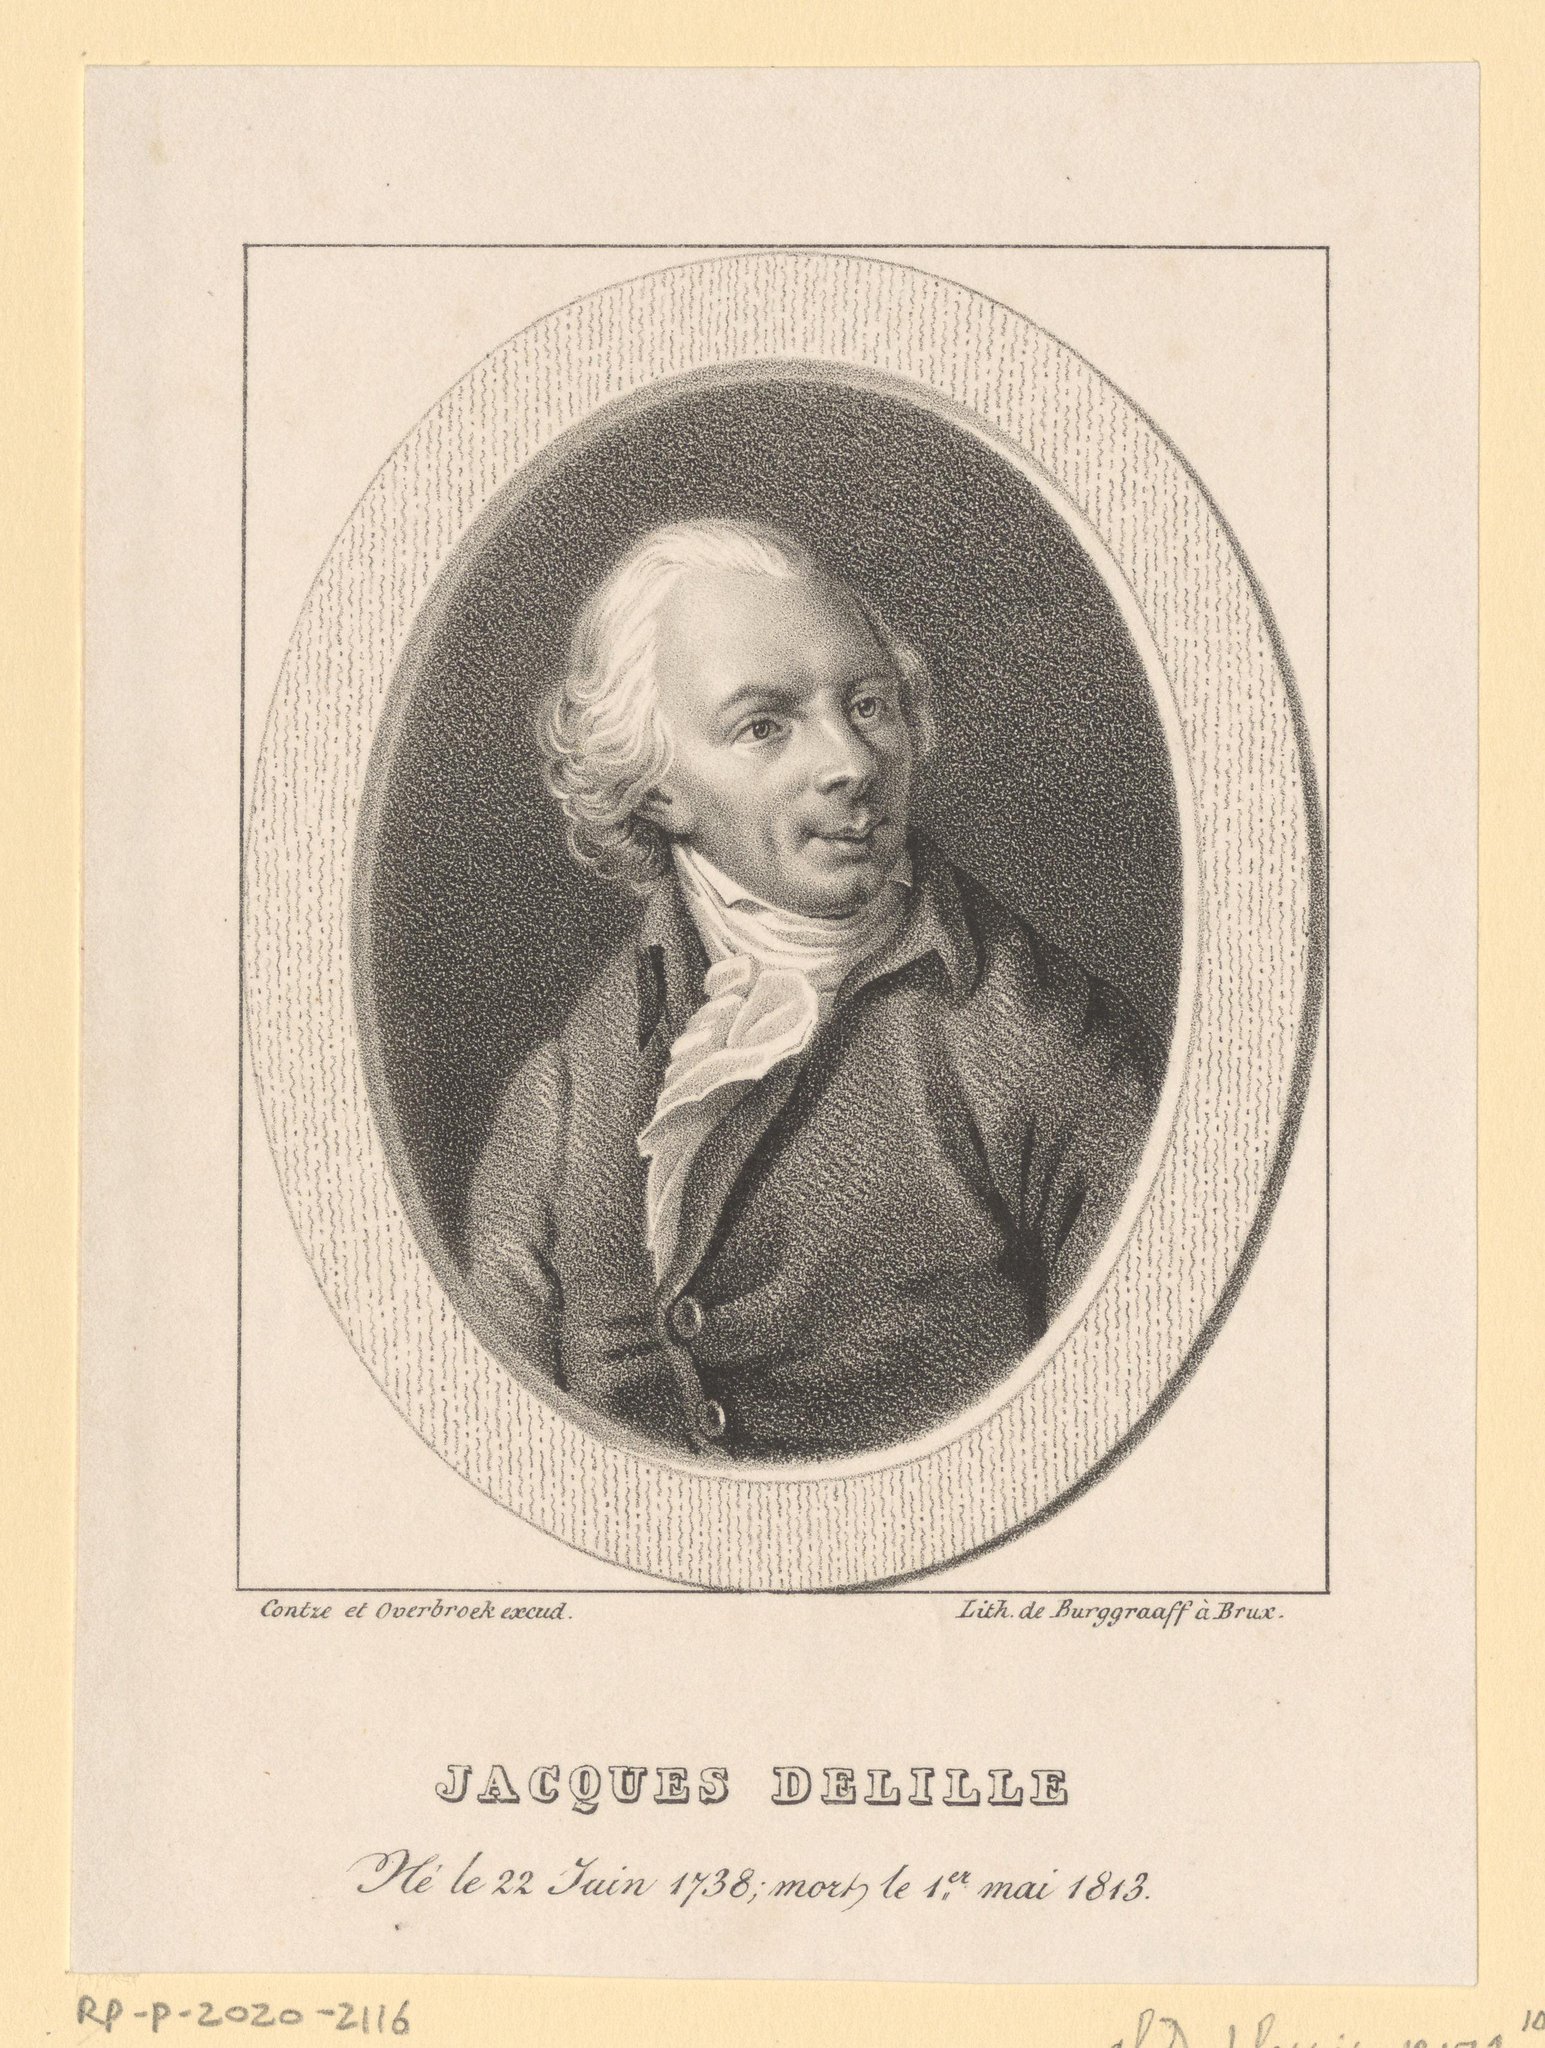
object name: print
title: Portret van Jacques Delille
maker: burggraaff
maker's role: printer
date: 1813-1850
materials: paper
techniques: lithograph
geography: brussels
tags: paris, jacques delille, historical persons, portrait of a writer, writer, poet, author